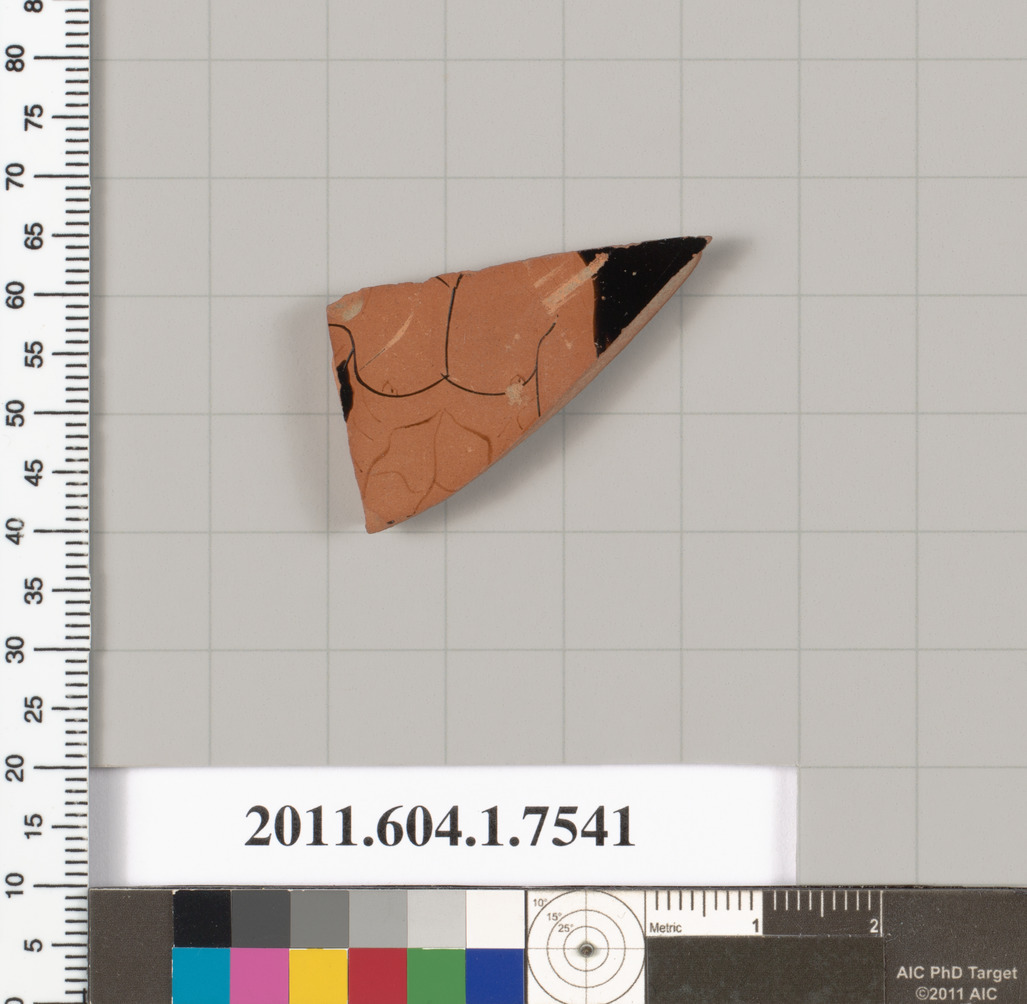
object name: kylix fragment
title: Terracotta fragment of a kylix (drinking cup)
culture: greek, attic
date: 460-450 BCE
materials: terracotta